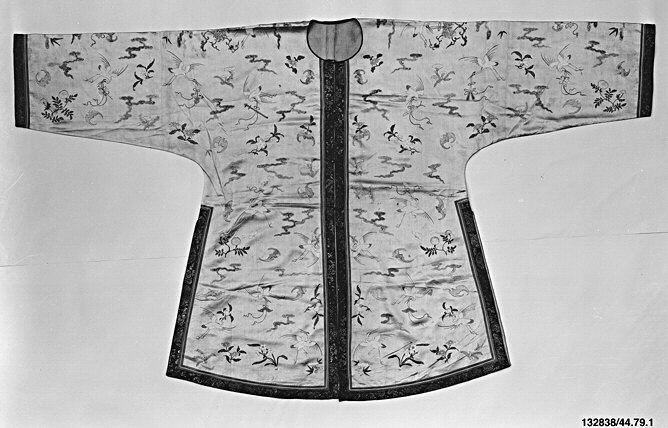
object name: woman's birthday jacket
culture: chinese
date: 1701-1800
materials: silk